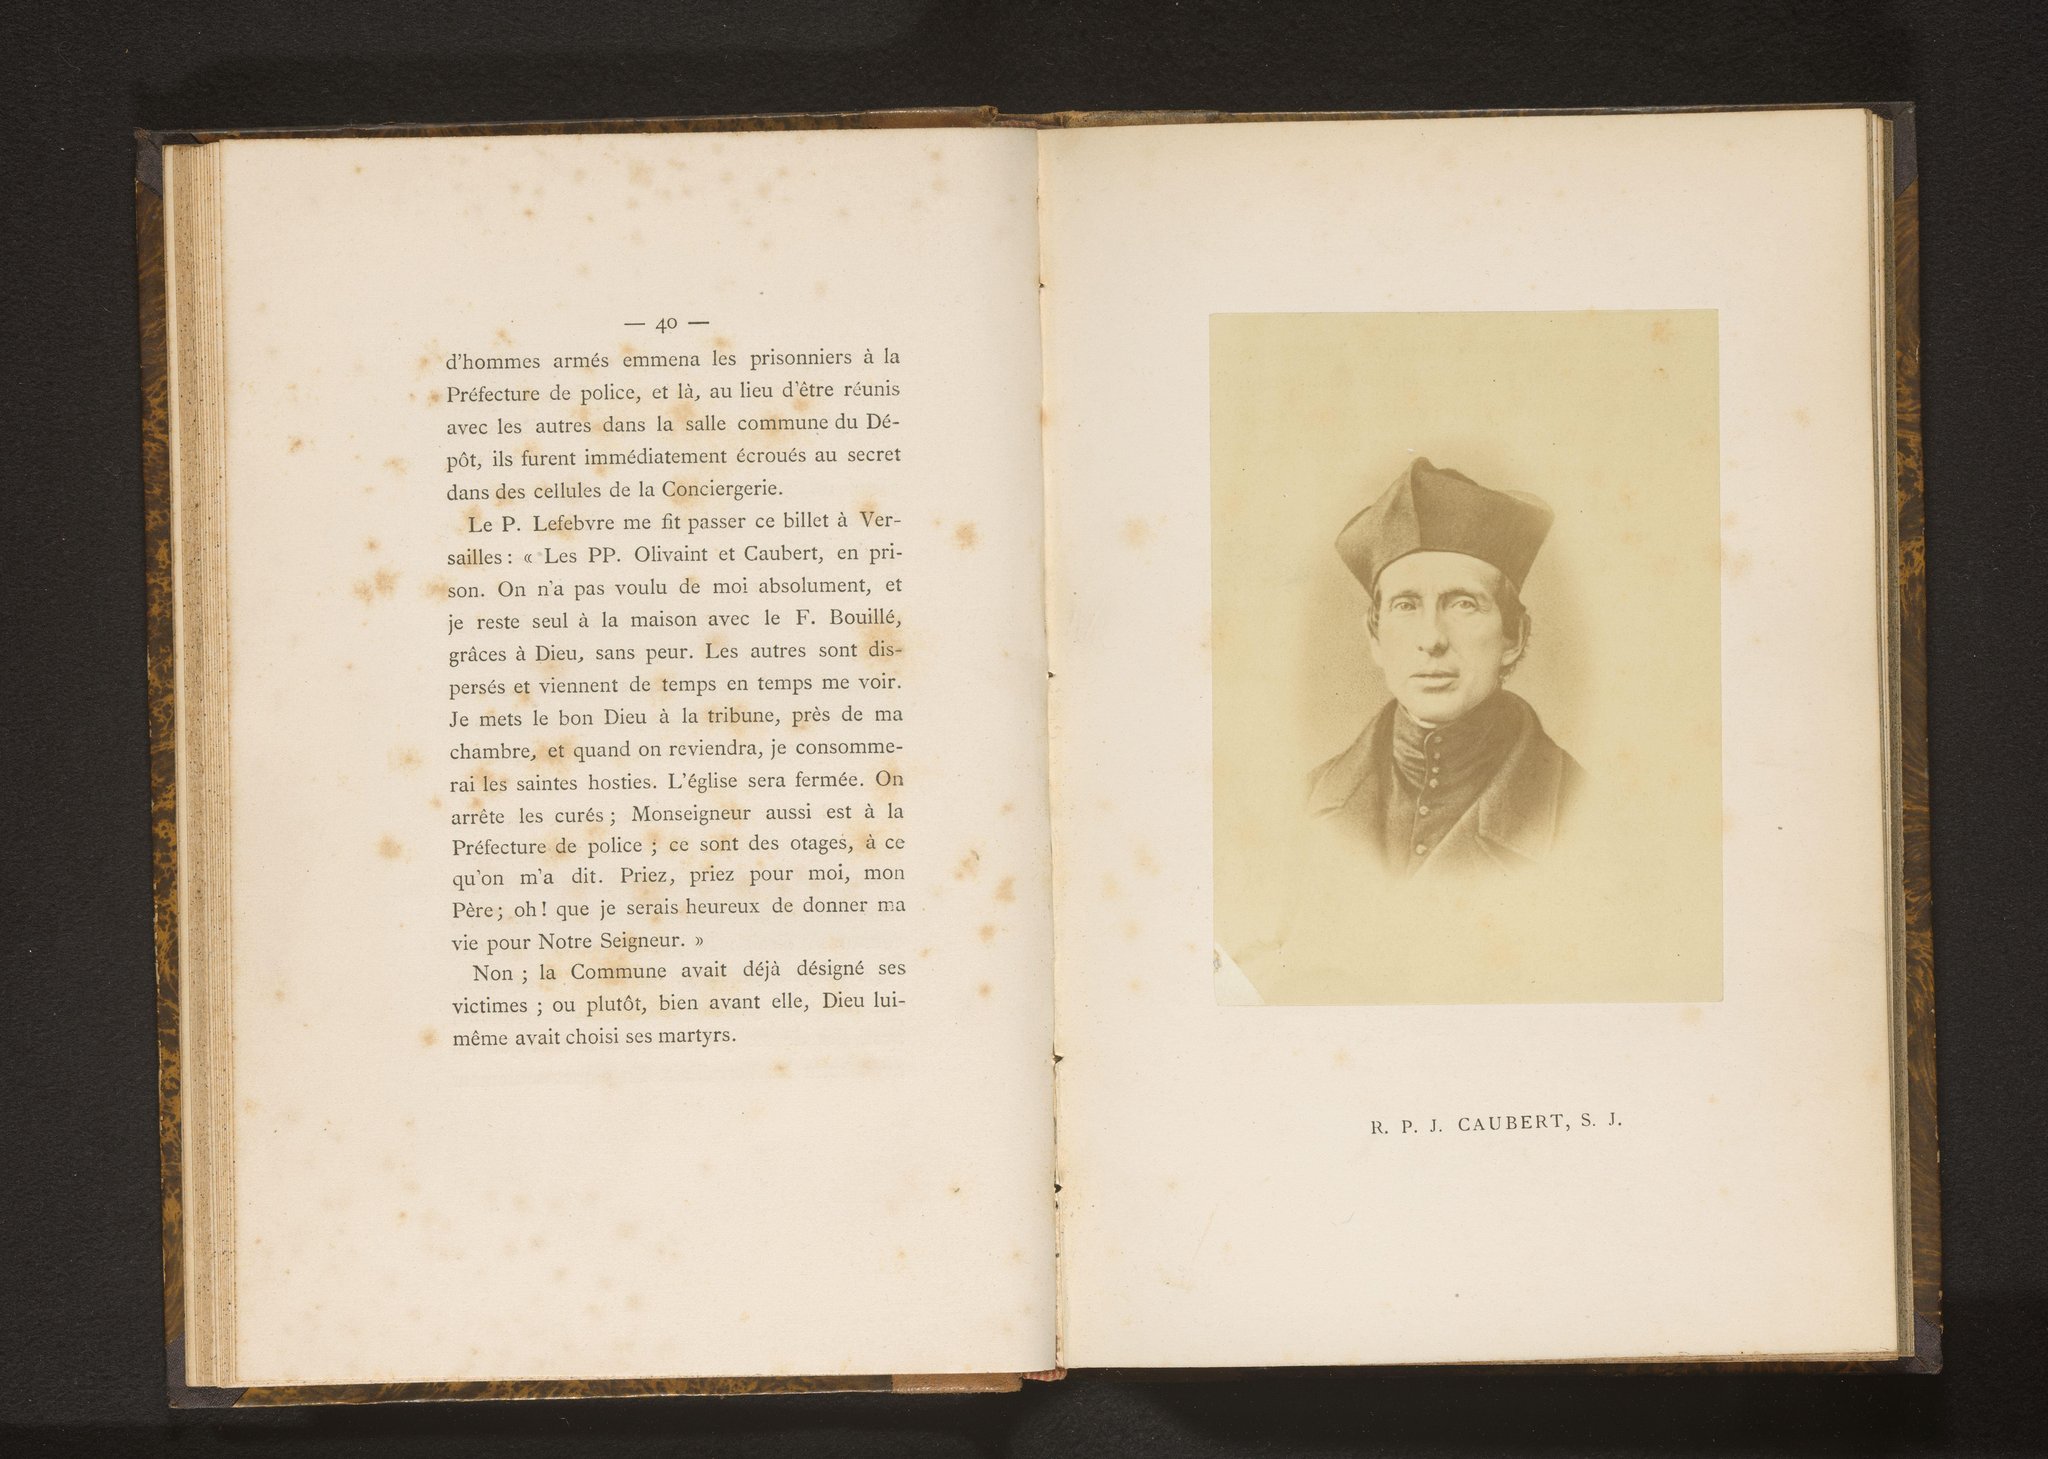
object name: photograph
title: Portret van Jean Caubert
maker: Anonymous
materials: photographic support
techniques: albumen print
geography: france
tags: monk(s), friar(s)